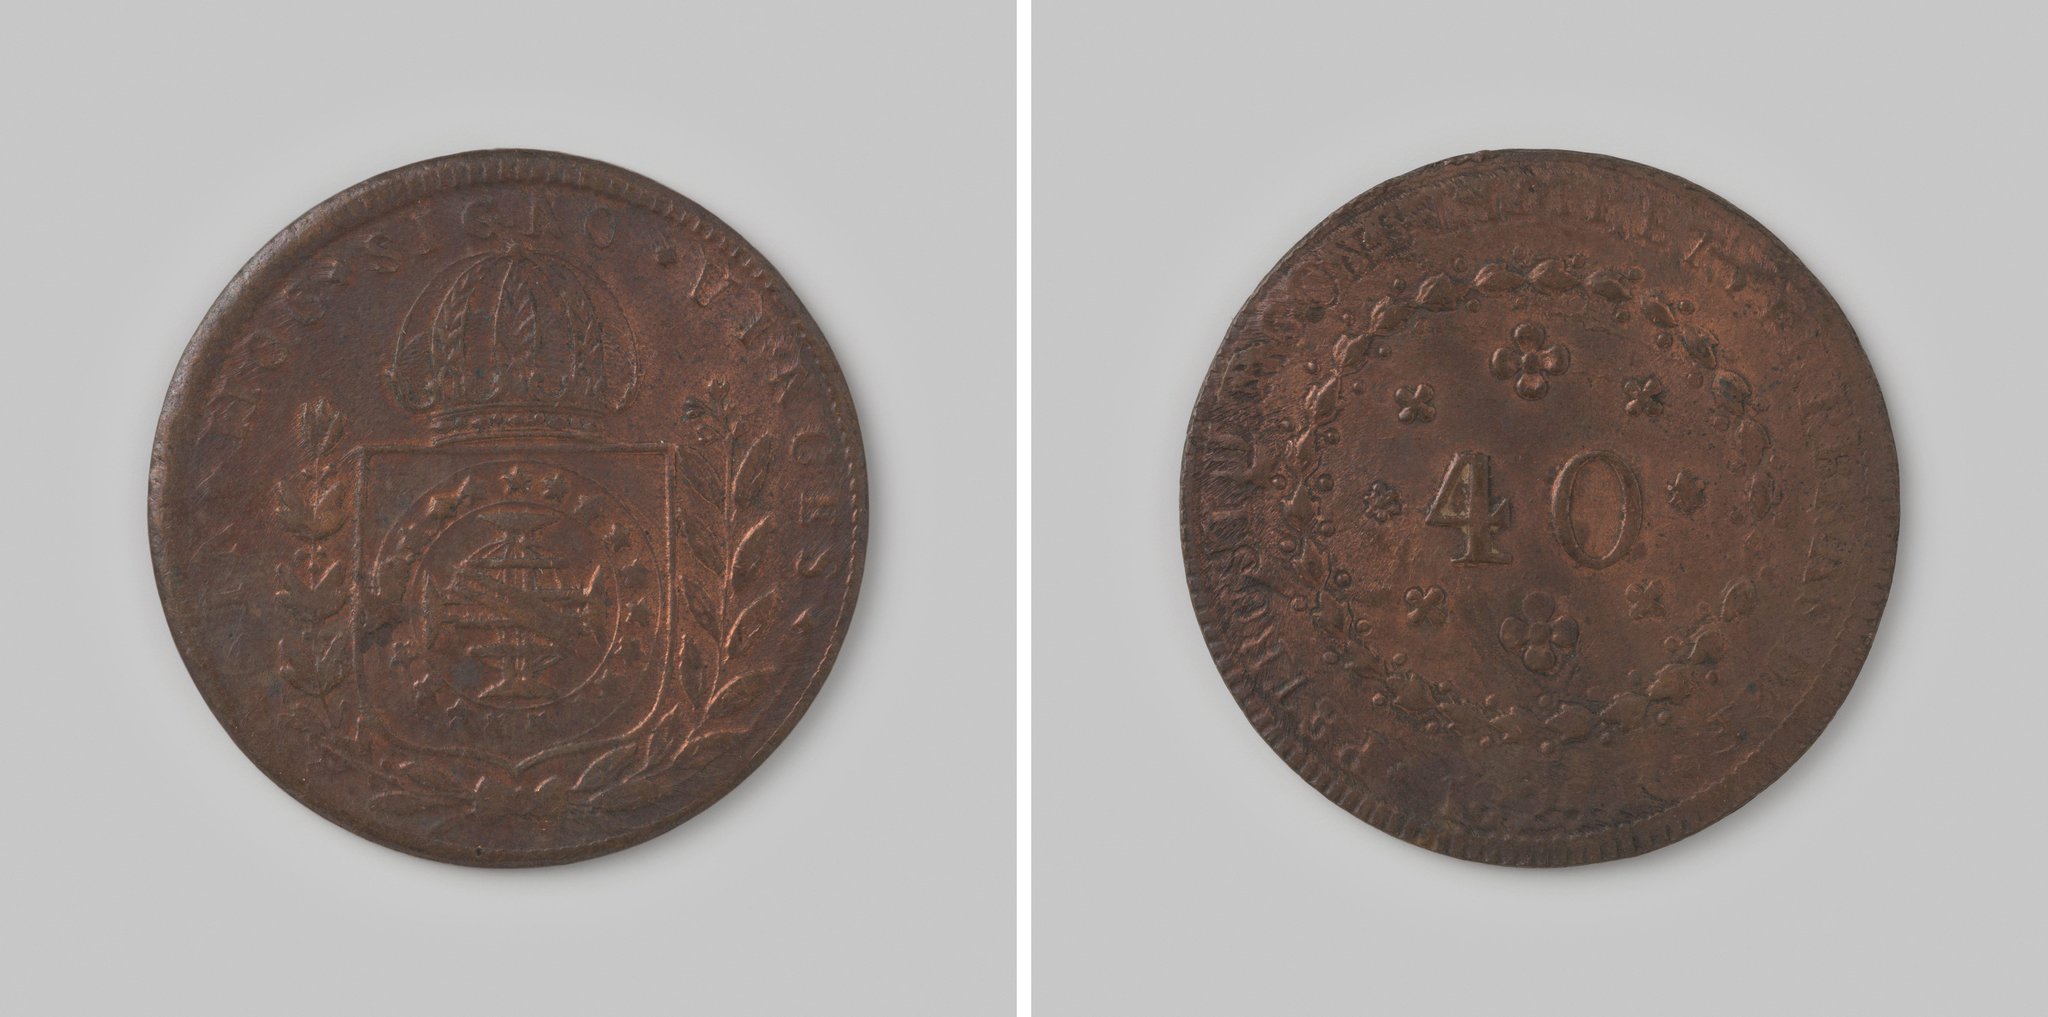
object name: coin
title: 40 reis van het keizerrijk Brazilië van D. Pedro I, 1824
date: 1824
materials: copper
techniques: striking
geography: rio de janeiro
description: Koperen munt. Voorzijde: tussen twee samengebonden takken gekroond wapenschild van Brazilië. Keerzijde: binnen cirkel van bloemen waarde-aanduiding: 40. In omschrift onderaan jaartal met rechts daarvan letter R [=Rio]. Gladde rand.